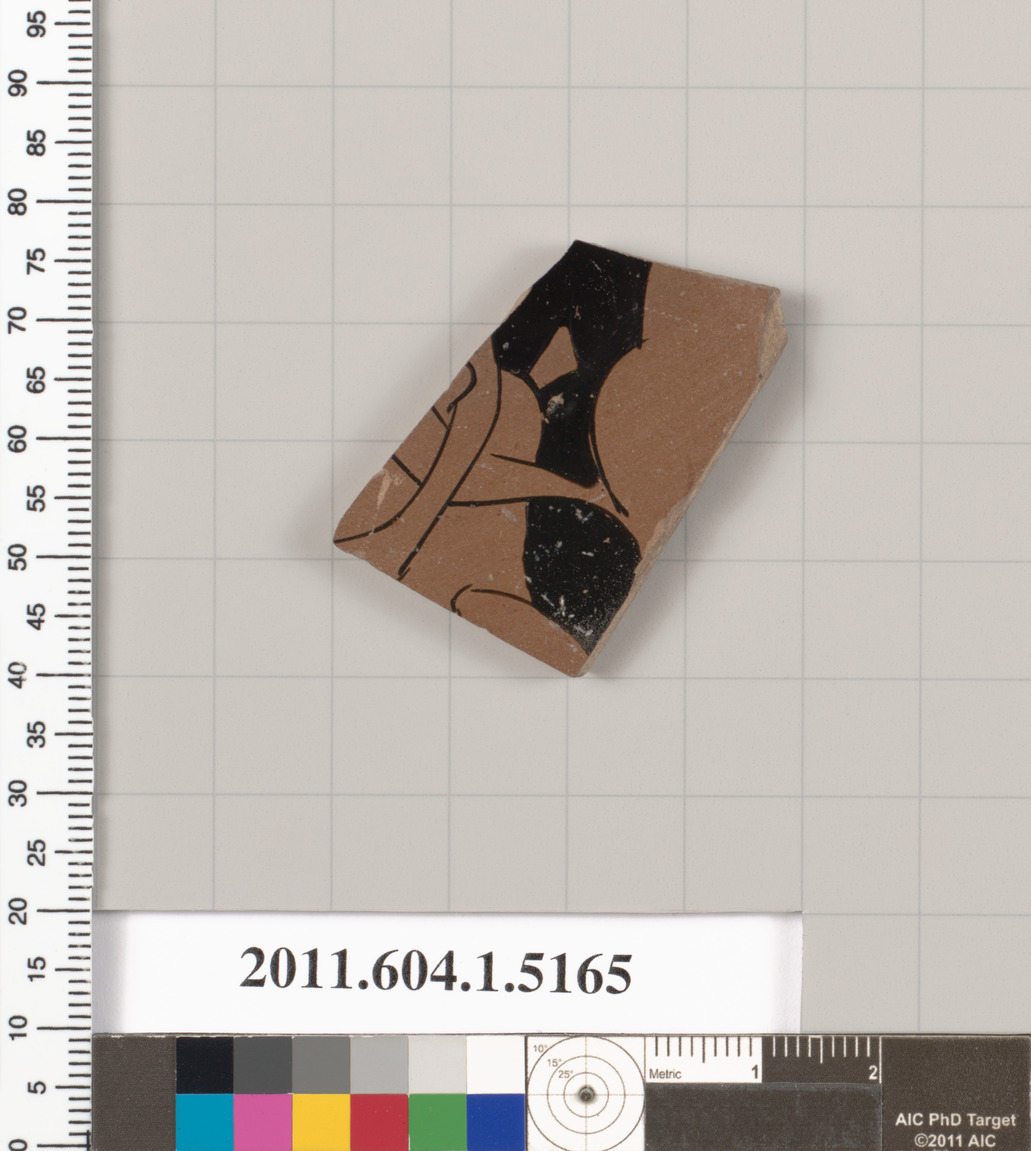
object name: kylix fragment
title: Terracotta fragment of a kylix (drinking cup)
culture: greek, attic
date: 500-480 BCE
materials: terracotta